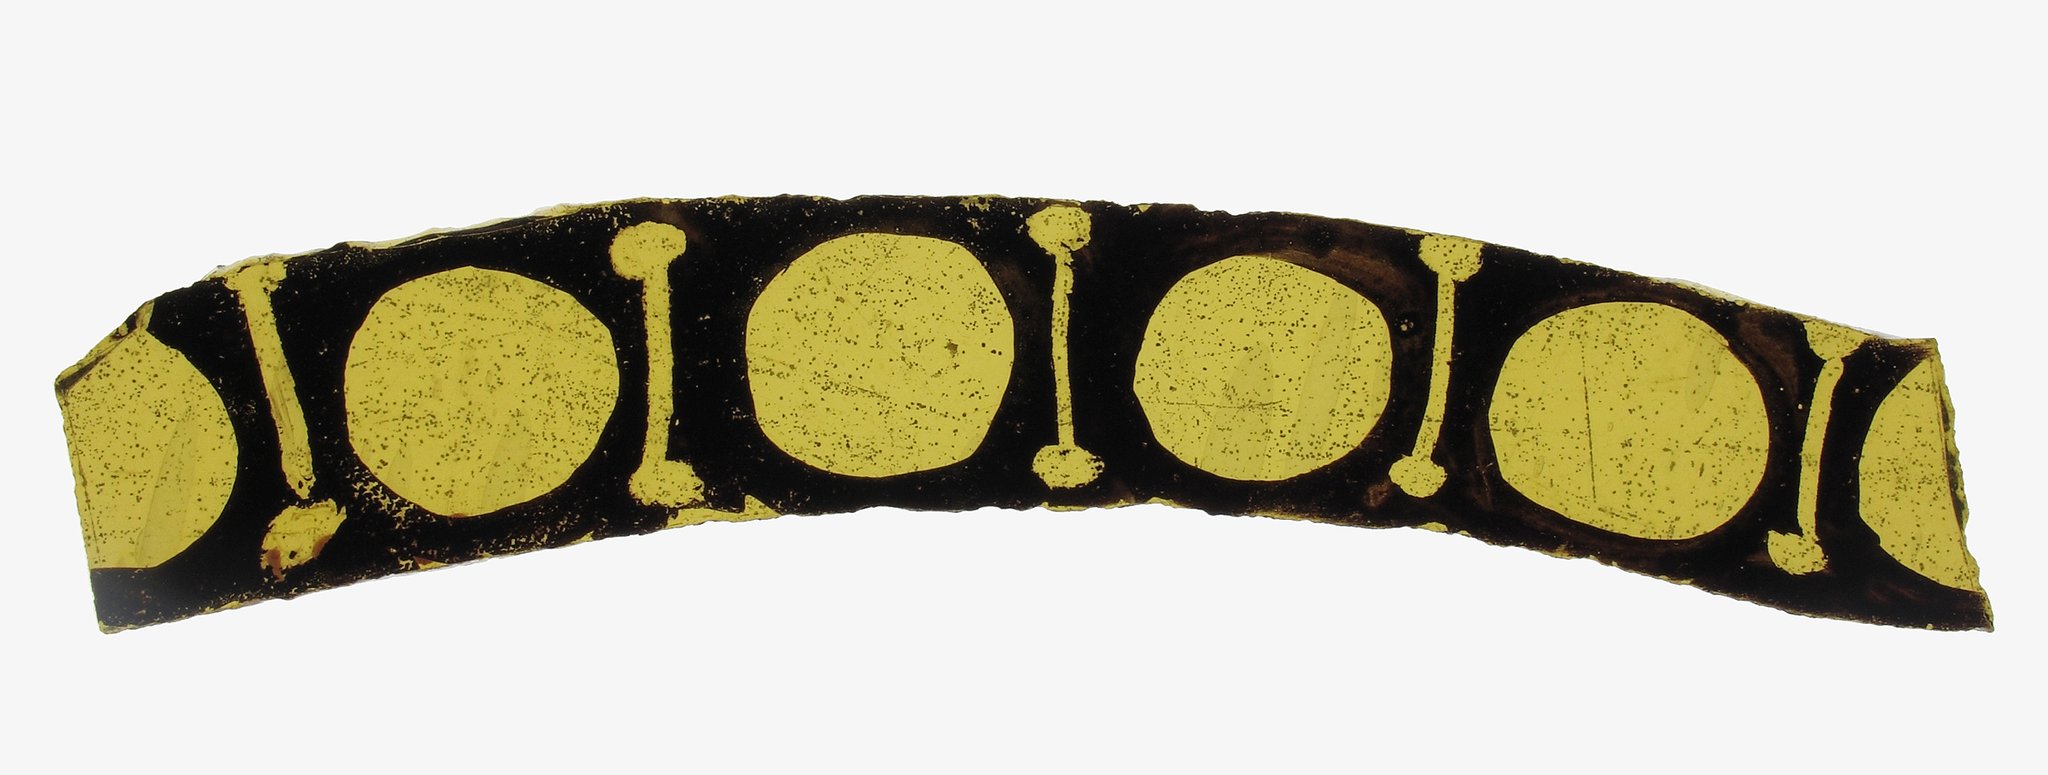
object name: fragment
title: Glass Fragment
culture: european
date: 1401-1500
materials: glass, metal